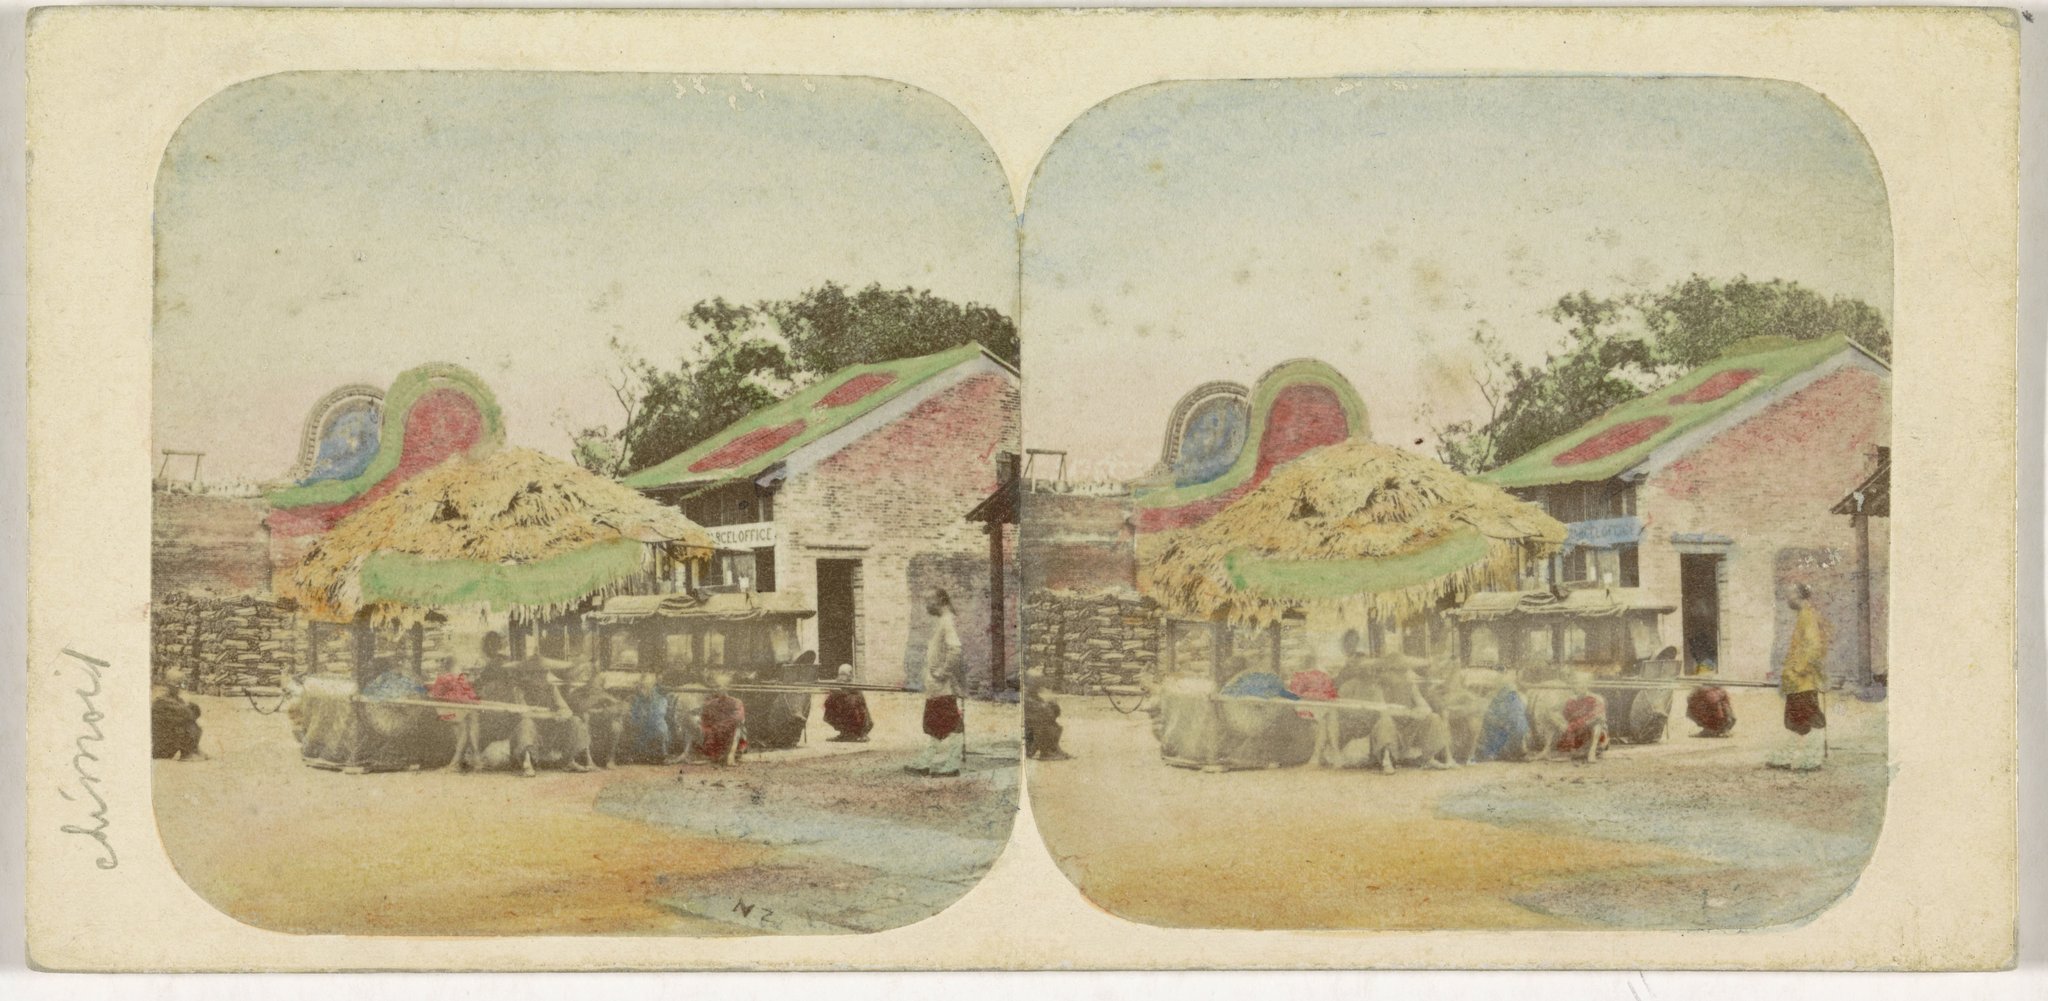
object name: stereograph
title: Views in China Canton Group of Palanquin Bearers, resting opposite the parcel office at Canton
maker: felice beato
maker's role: fotograaf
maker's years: 1825-1909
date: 1850-1860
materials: photographic support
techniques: albumen print, hand coloring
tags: kanton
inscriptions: title: ‘Views in China. 37 Canton. Group of Palanquin Bearers, resting opposite the parcel office at canton.’, annotation: ‘chimoit (?)’, number: ‘30’